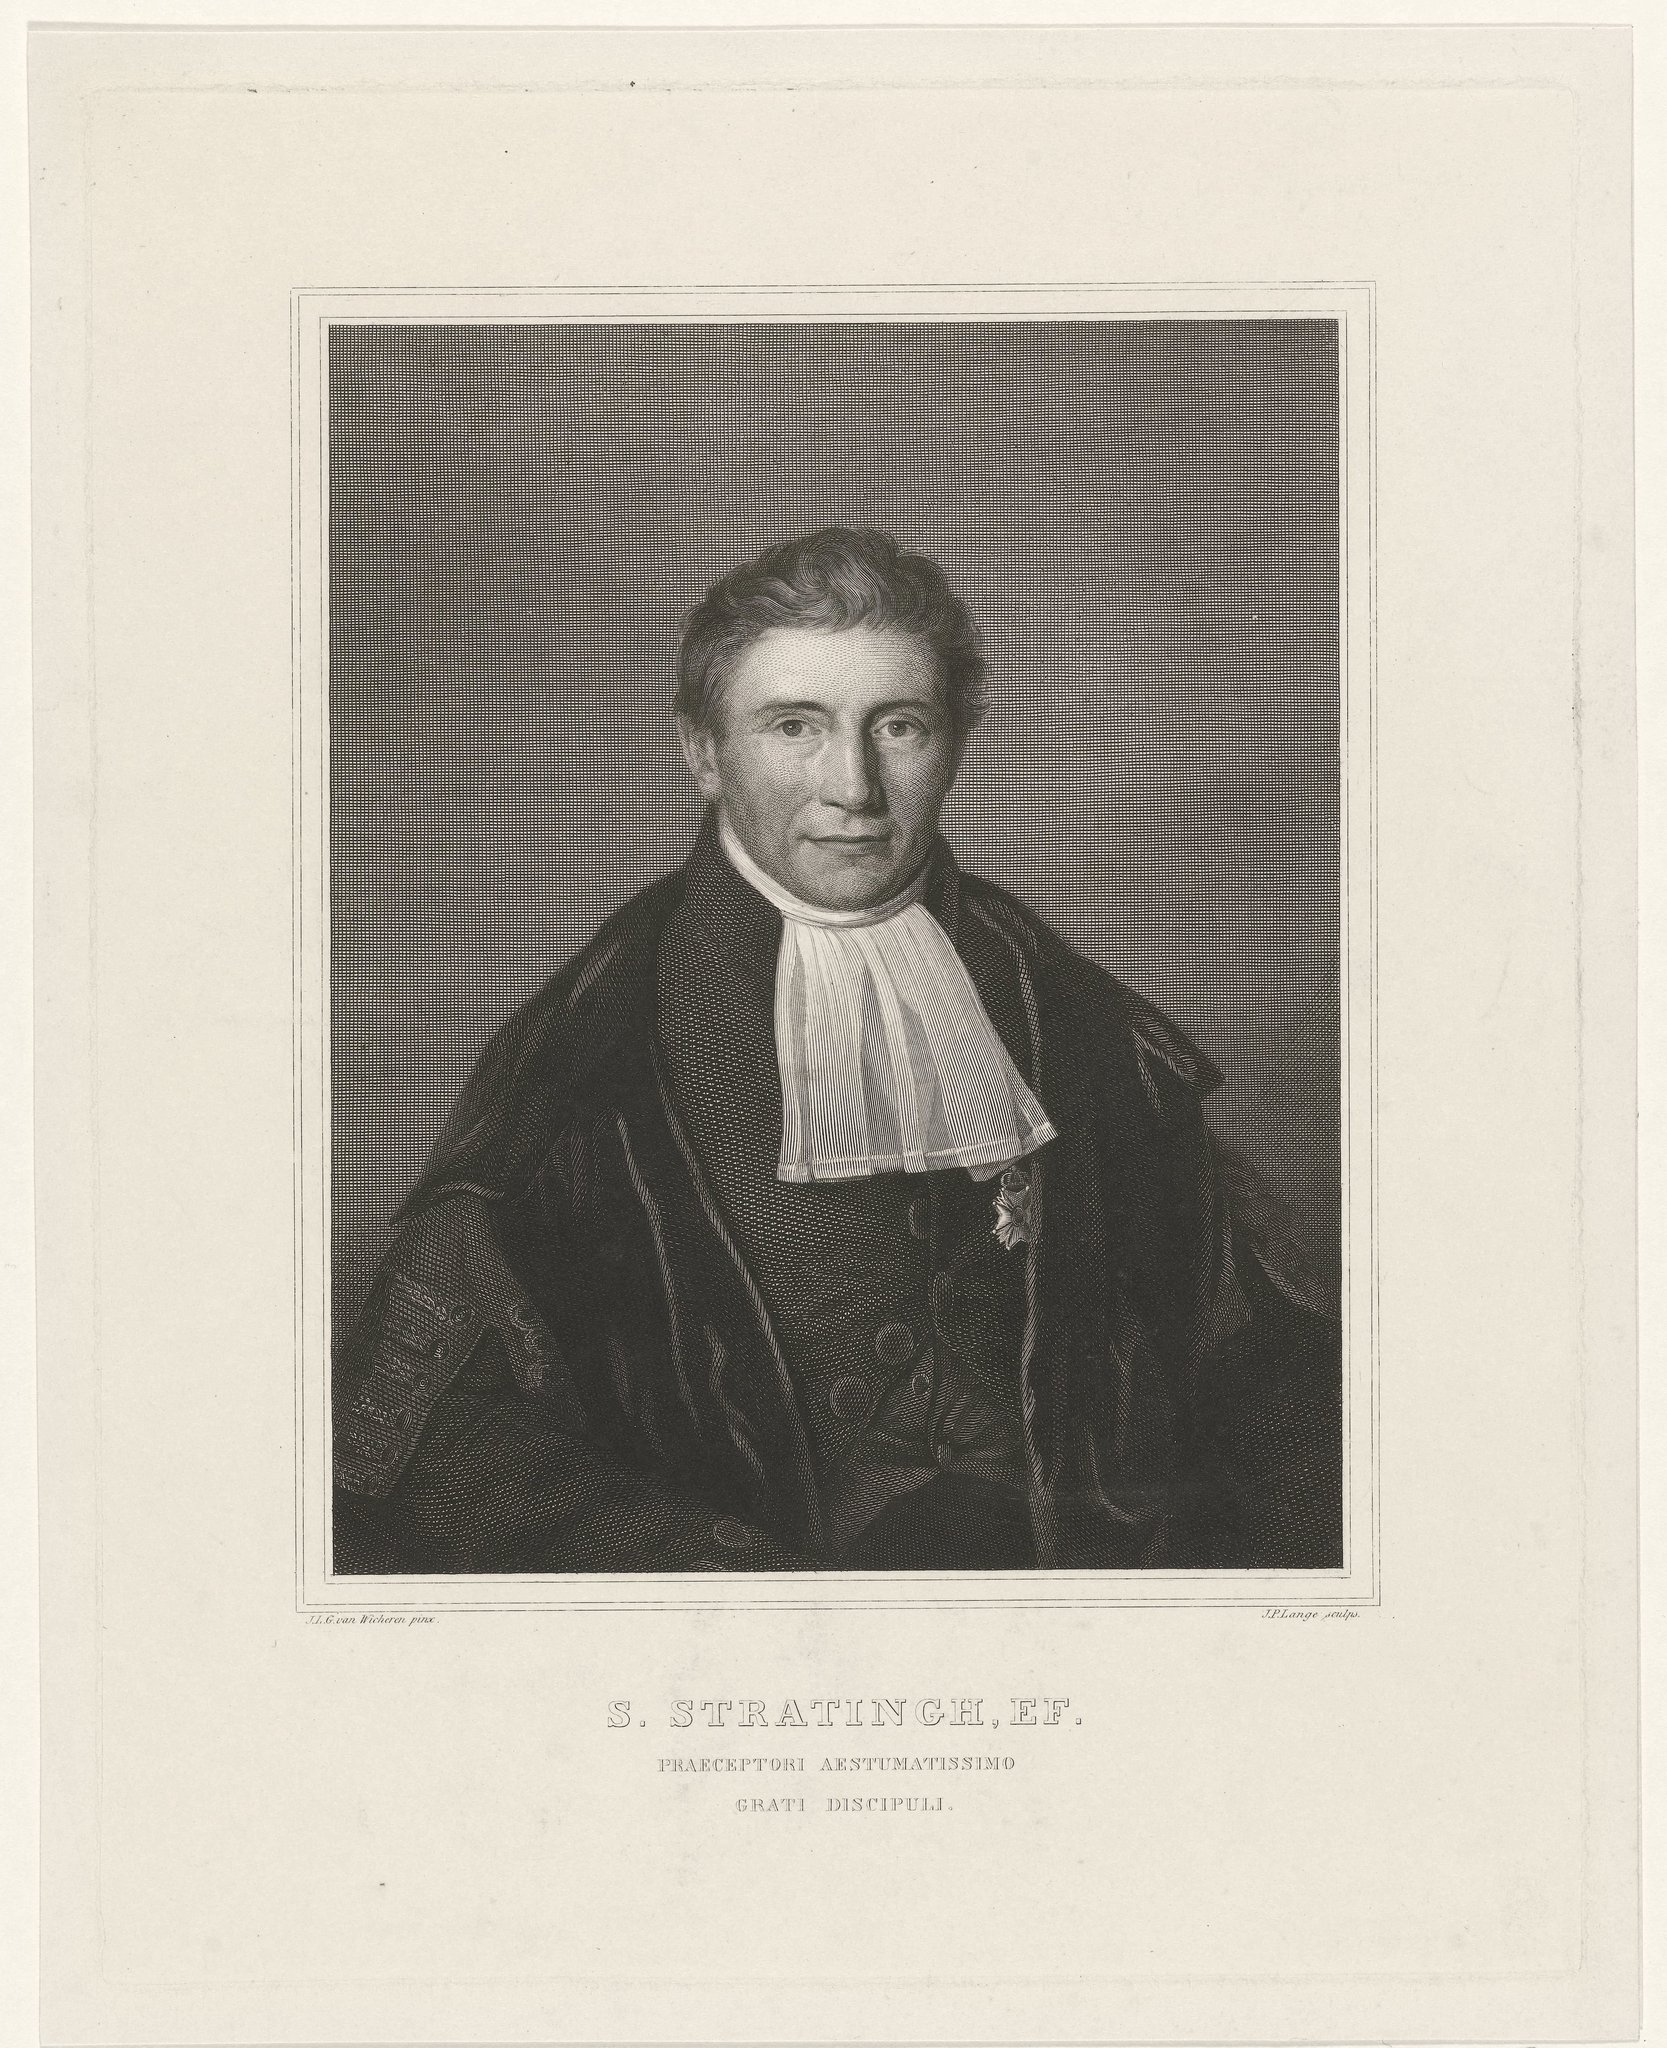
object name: print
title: S. Stratingh, Ef.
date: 1833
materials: paper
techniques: engraving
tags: adorp, groningen, hoogleraar, chemicus, sibrandus stratingh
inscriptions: collector's mark: Lugt 2228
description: Portretbuste van Sibrandus Stratingh, hoogleraar scheikunde te Groningen. Hij is gehuld in een toga met bef en draagt een ridderorde op de borst.